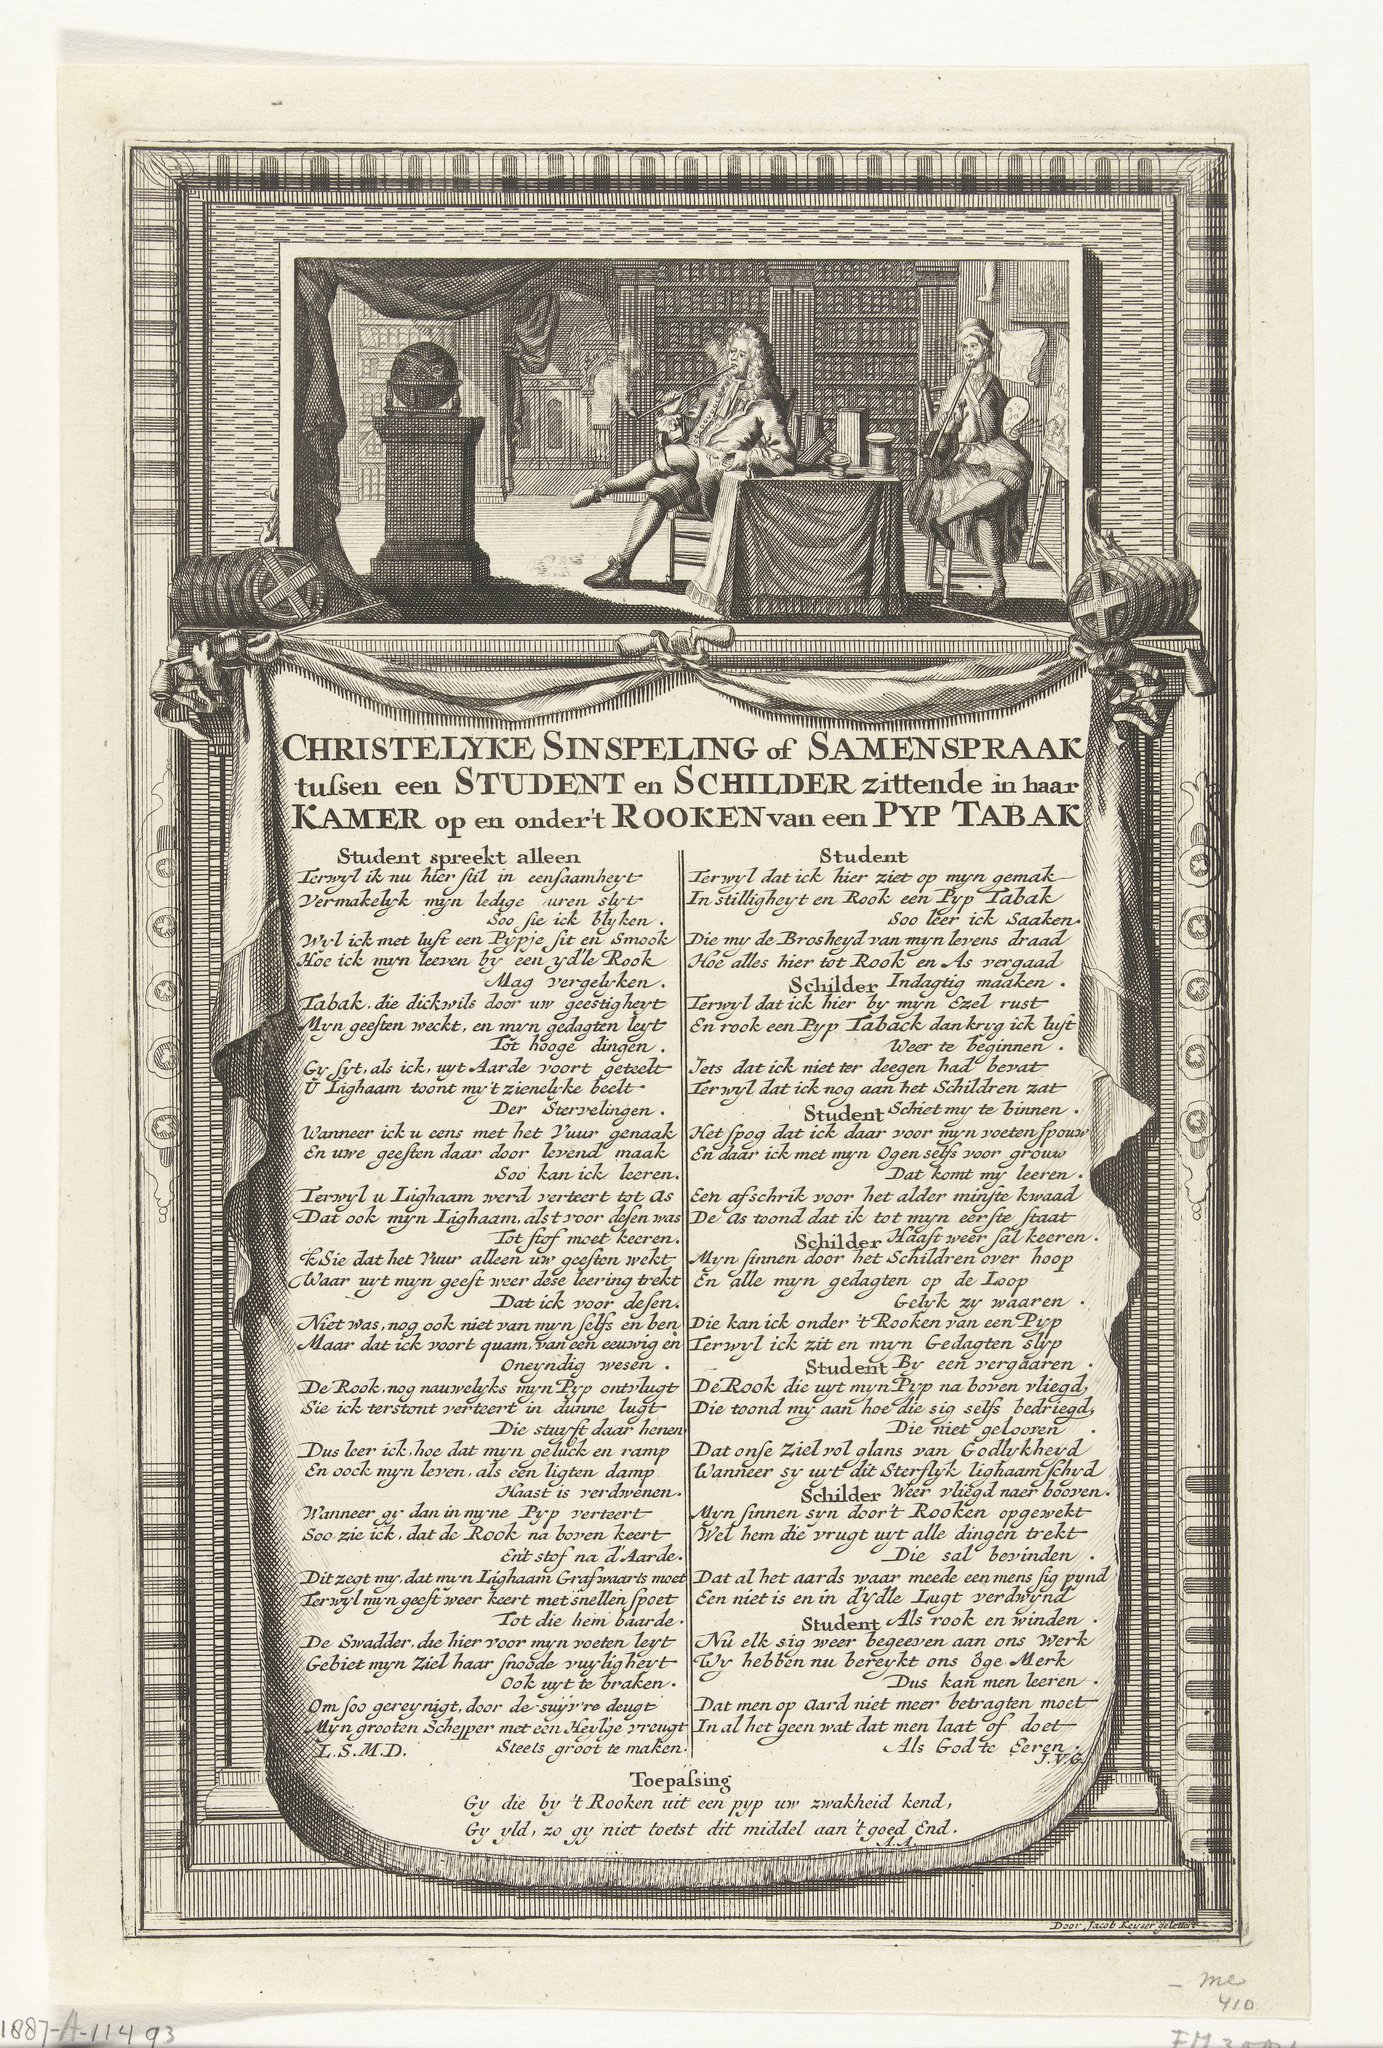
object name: print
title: Christelyke Sinspeling of Samenspraak tussen een Student en Schilder zittende in haar Kamer op en onder 't Rooken van een Pyp Tabak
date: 1690-1710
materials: paper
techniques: engraving, etching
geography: northern netherlands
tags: pipe ~ tobacco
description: Samenspraak tussen een student en een schilder over het roken van een pijp, ca. 1700. De student aan een tafel in een studeervertrek vol met boeken, de schilder gezeten voor zijn ezel. Onder de voorstelling een samenspraak in twee kolommen. De verzen gesigneerd L.S.M.D. en J.V.G.